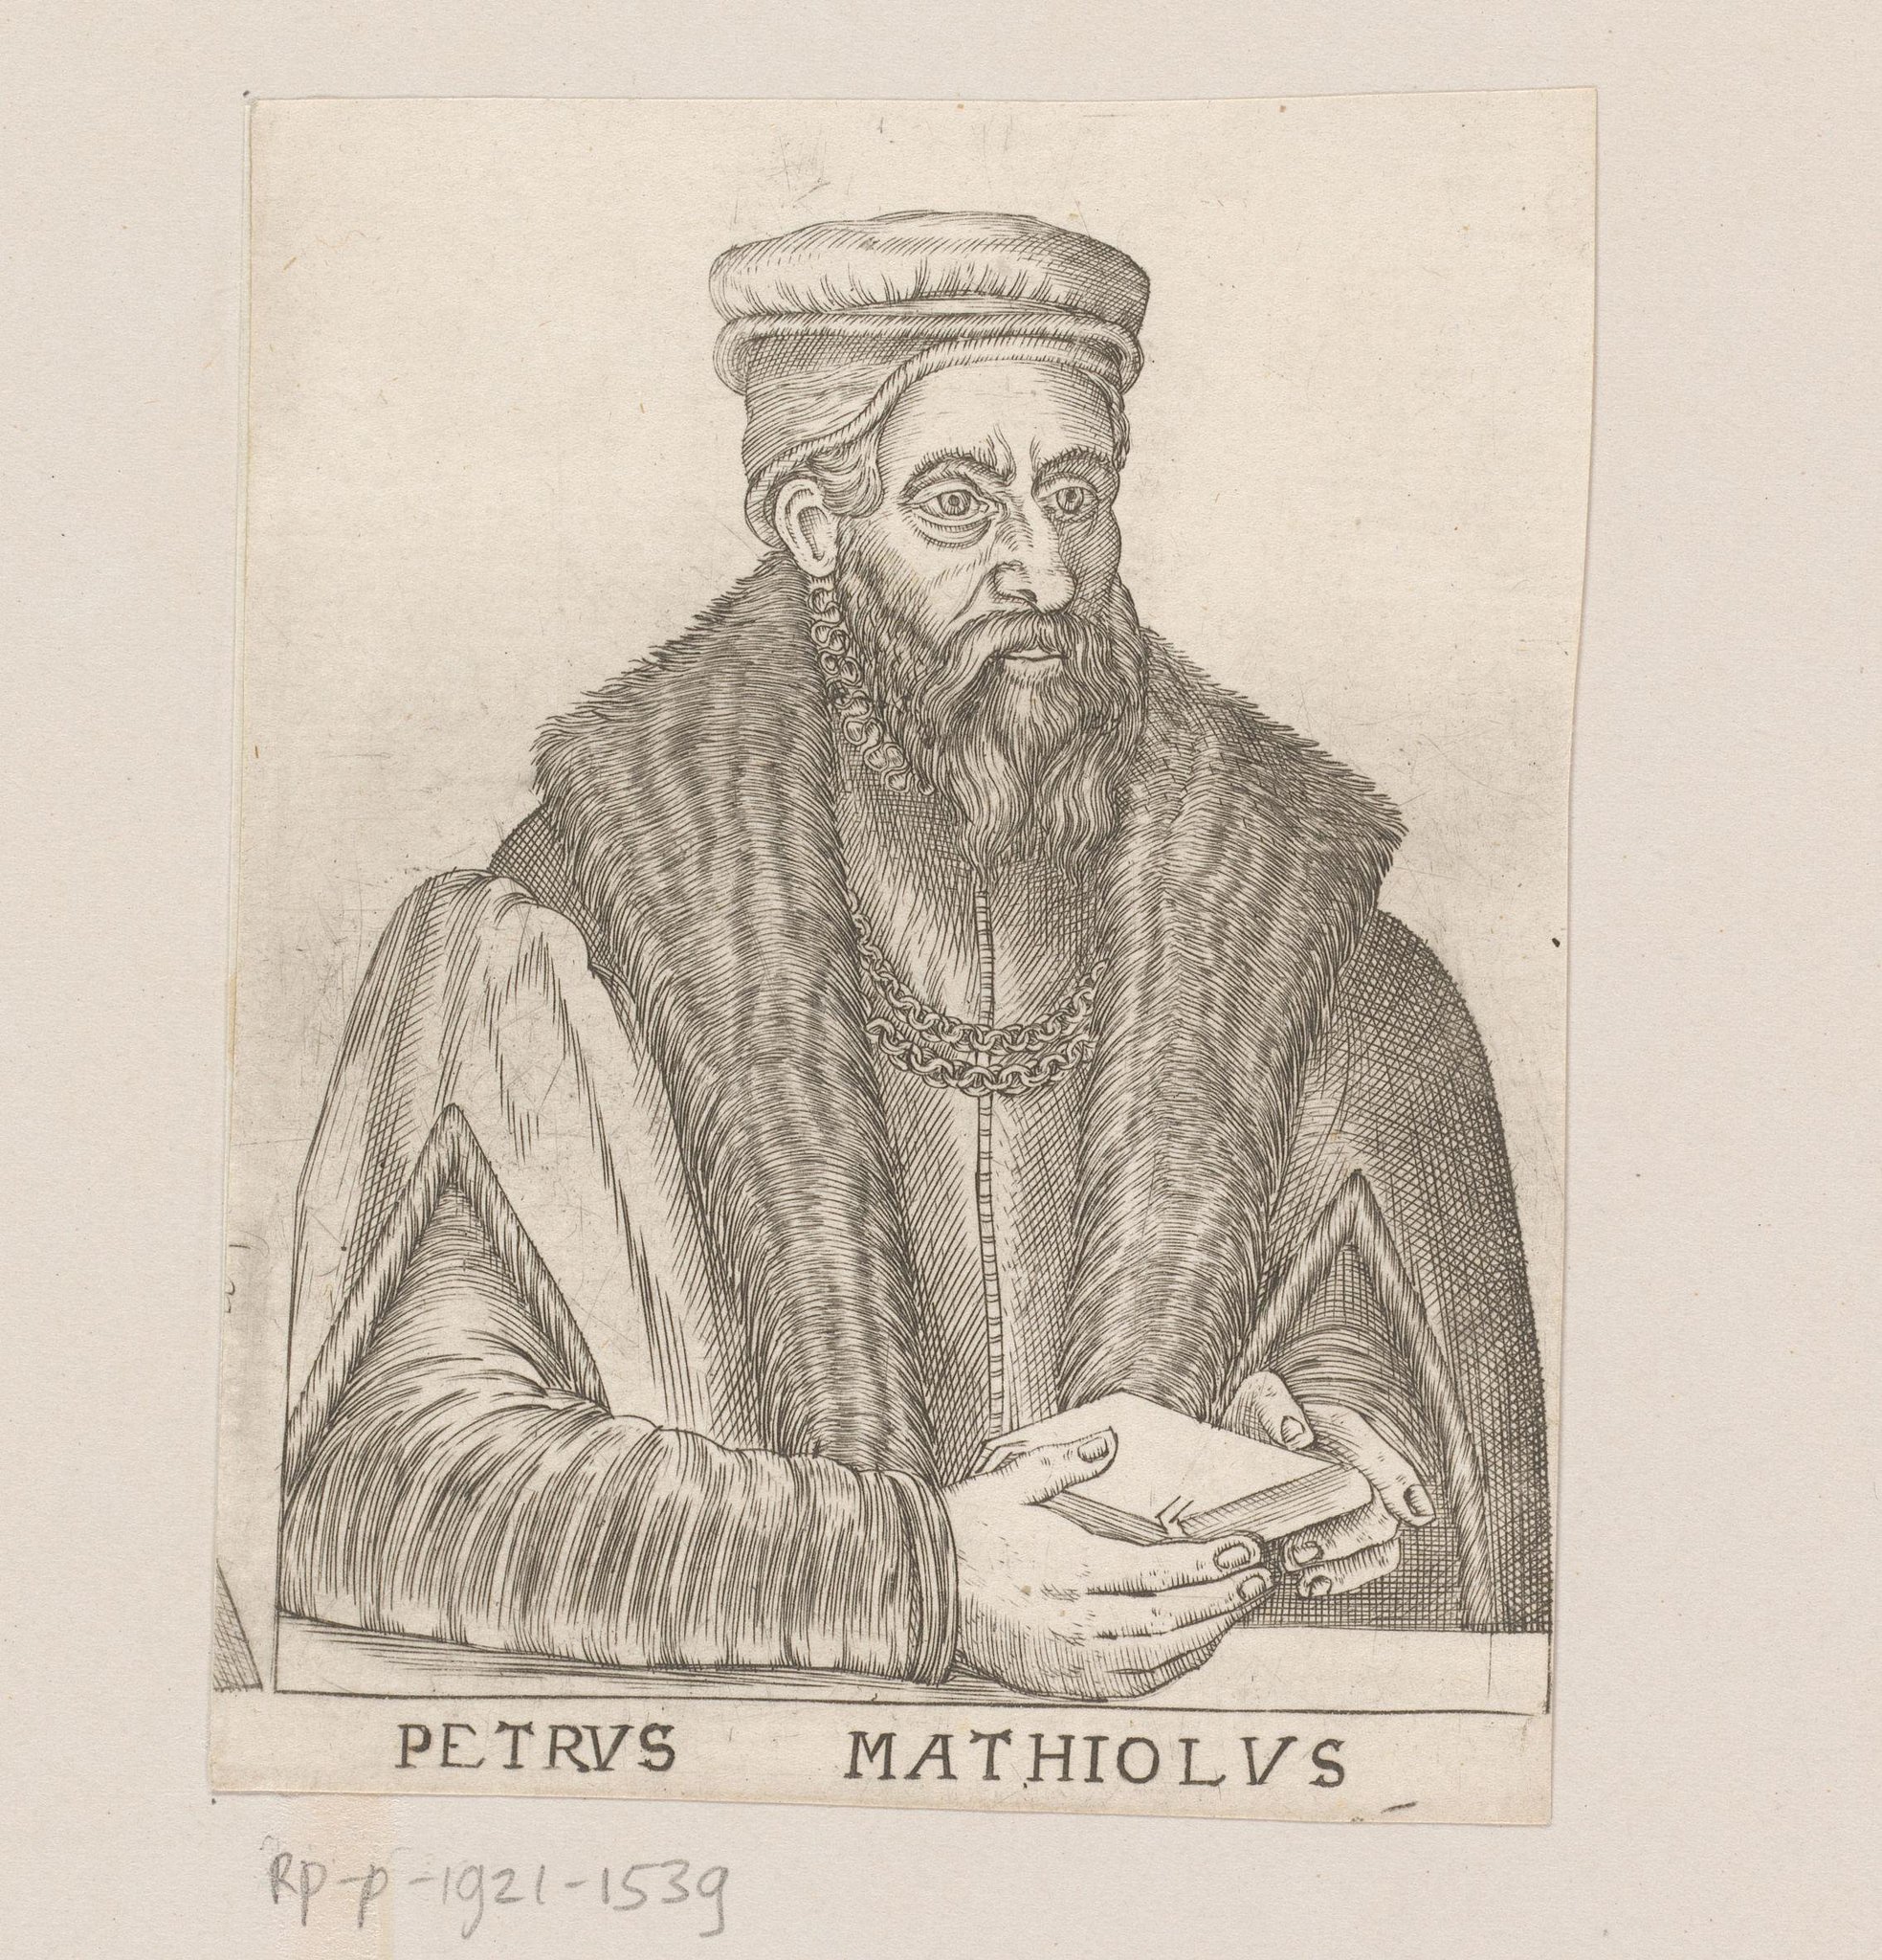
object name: print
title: Petrus Mathiolus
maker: Anonymous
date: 1570-1650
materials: paper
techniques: engraving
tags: botany (+ portrait of scholar, scientist), historical persons, book, physician, doctor (+ portrait of scholar, scientist)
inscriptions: collector's mark: Lugt 2233